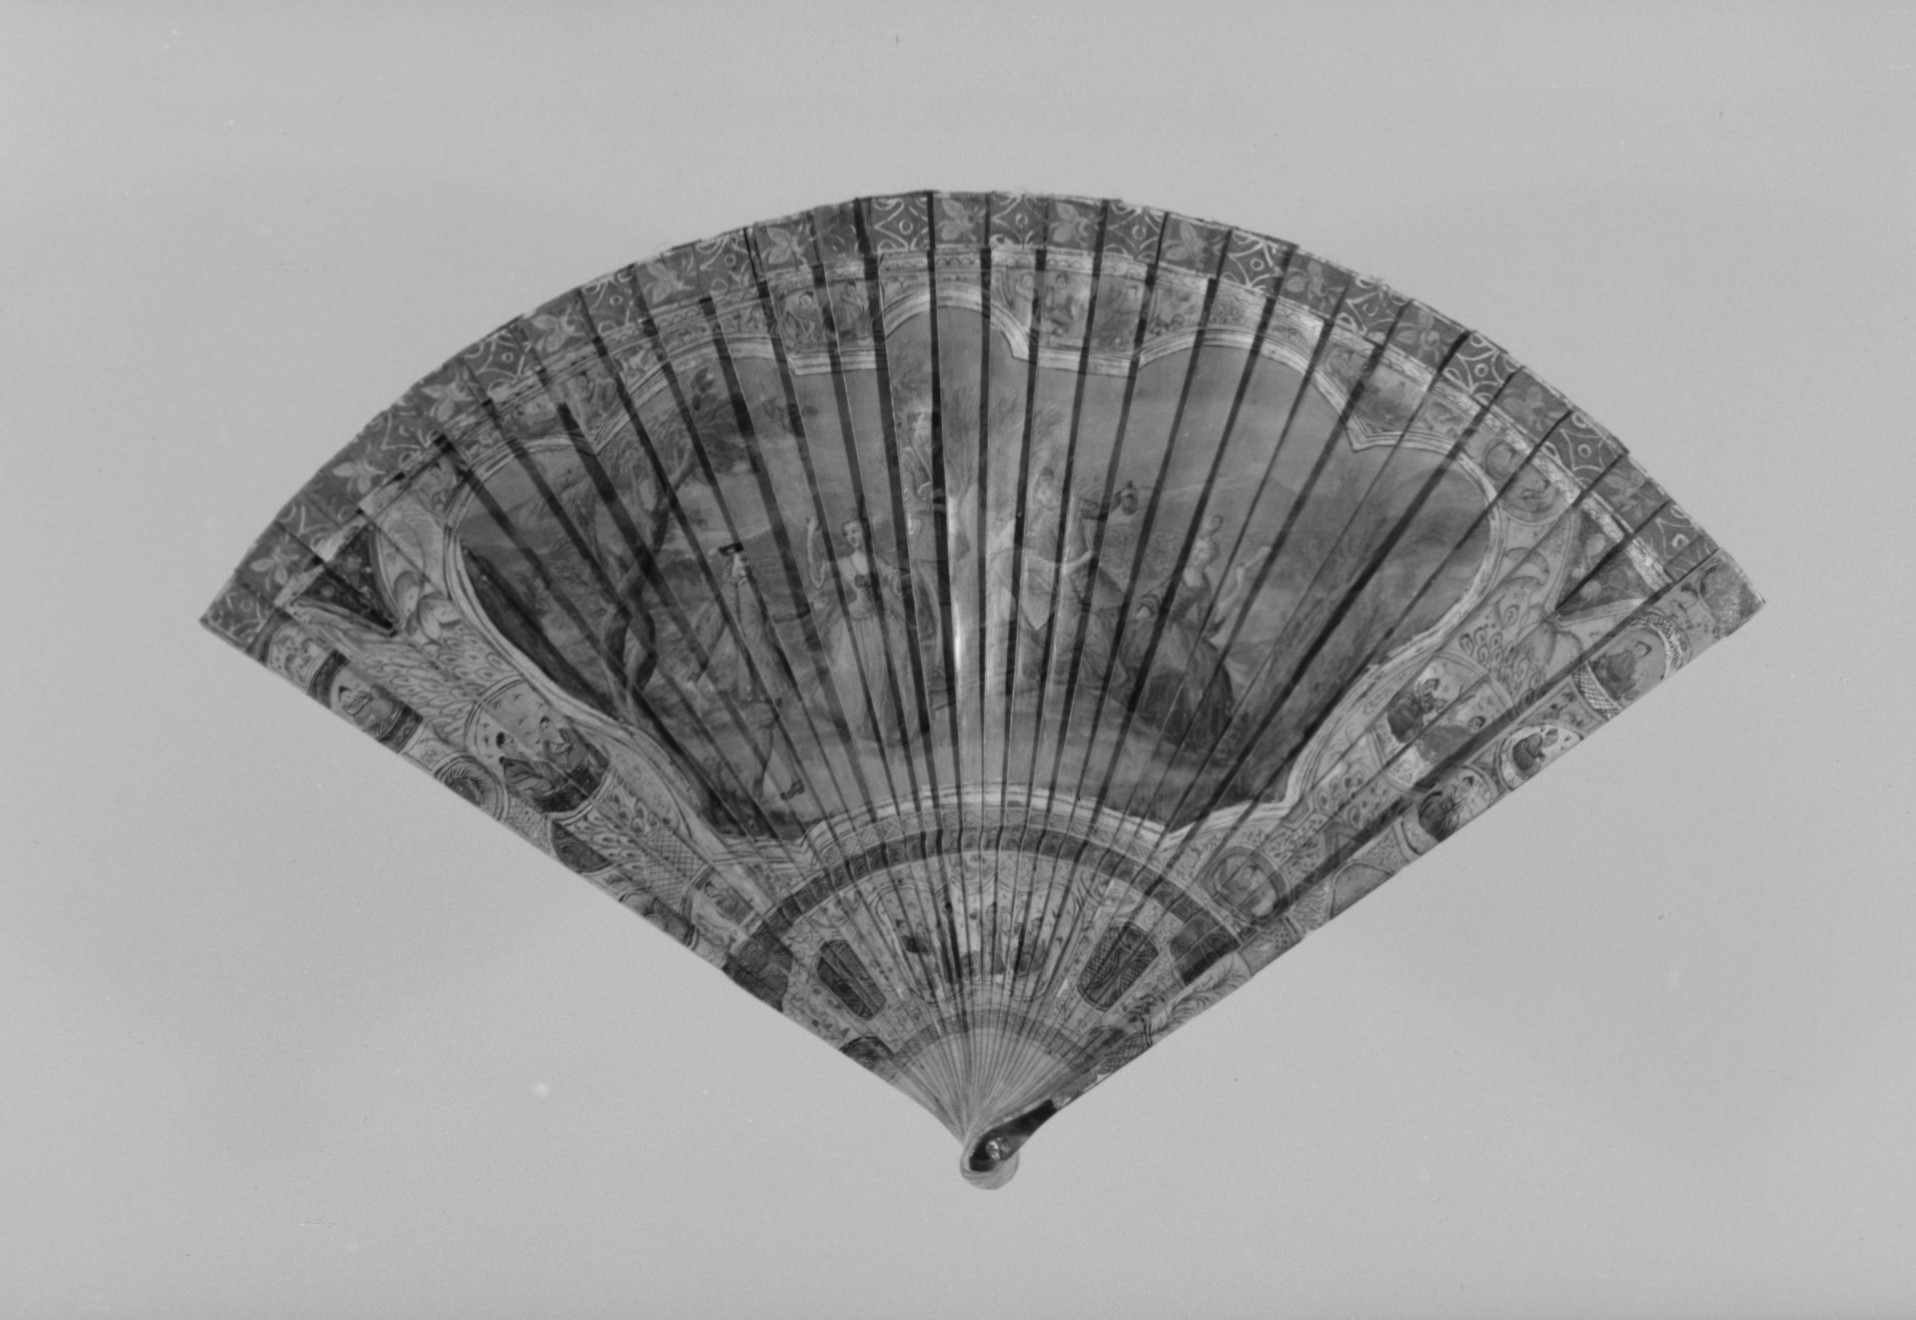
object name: fan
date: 1701-1800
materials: ivory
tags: men,women